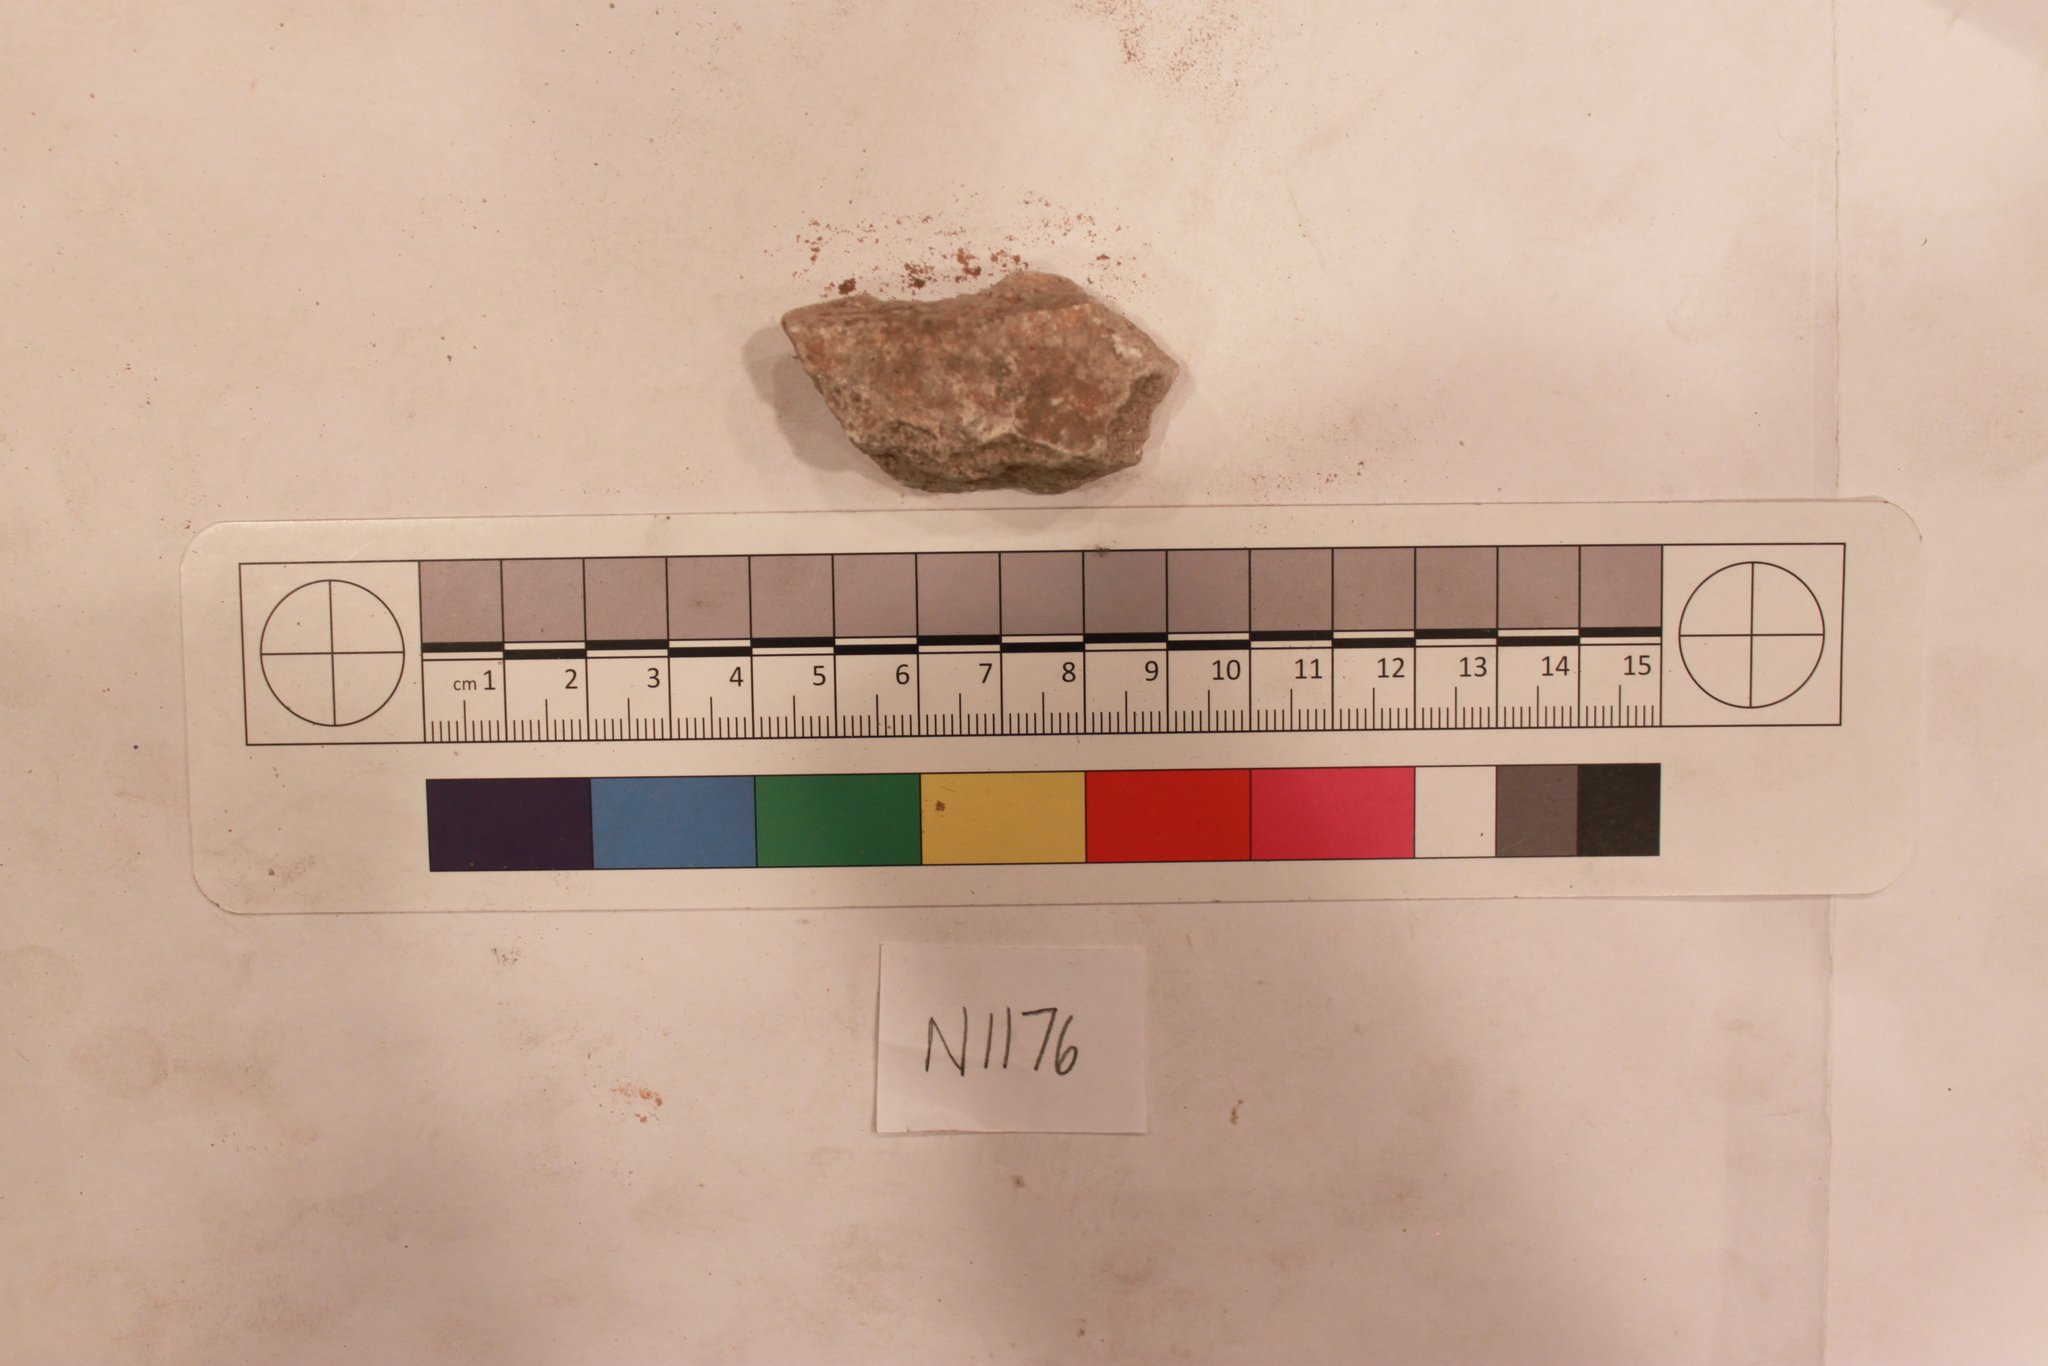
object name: fragment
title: Stucco Fragment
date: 701-1200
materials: plaster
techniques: carving, painting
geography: iran